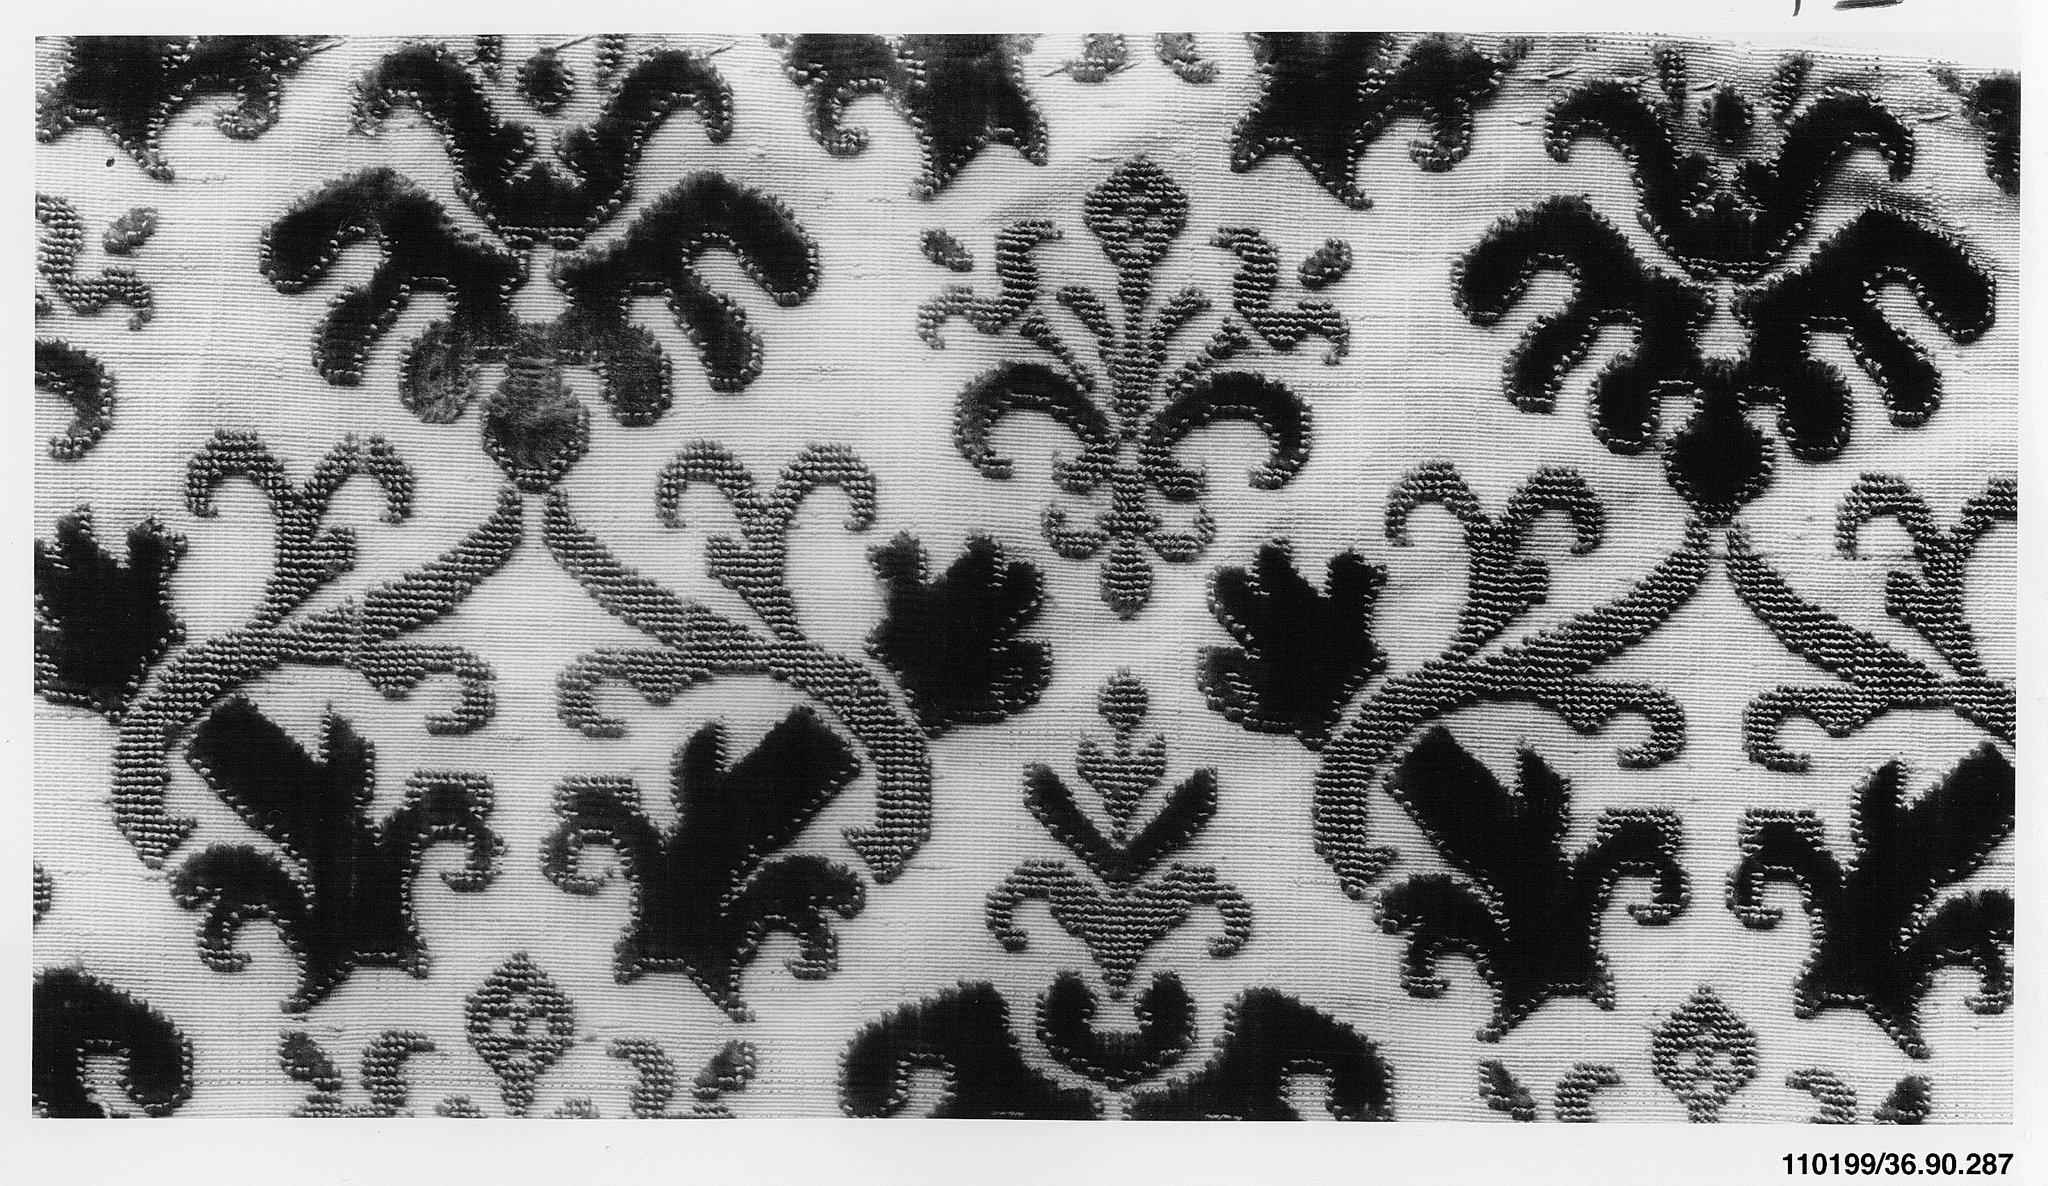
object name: piece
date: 1501-1700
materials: silk